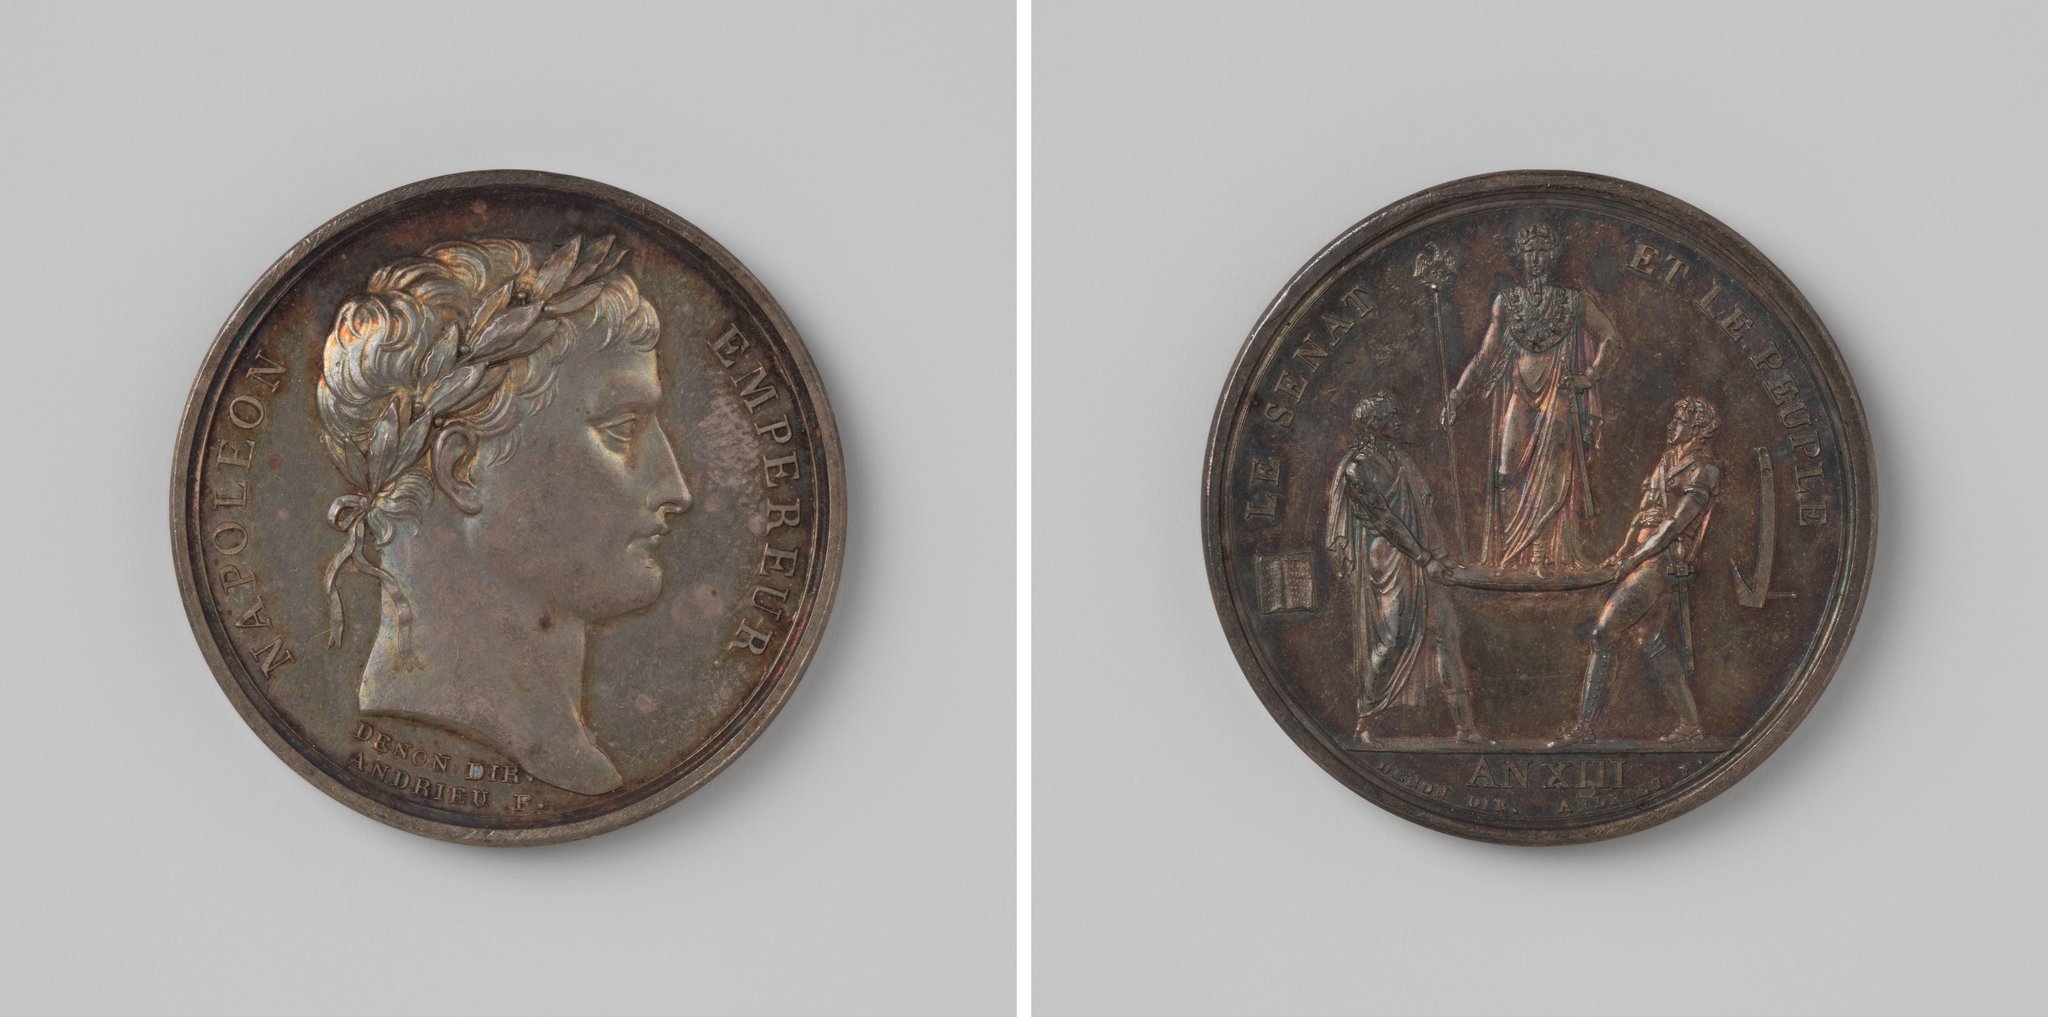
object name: history medal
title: Napoleon Bonaparte, keizer der Fransen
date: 1806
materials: silver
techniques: striking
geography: paris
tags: napoleon i (emperor of the french)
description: Zilveren penning. Voorzijde: borststuk man met lauwerkrans binnen omschrift. Keerzijde: Napoleon met veldteken in hand staat op schild dat wordt getild door Senaat en Volk binnen omschrift; afsnede: jaartal